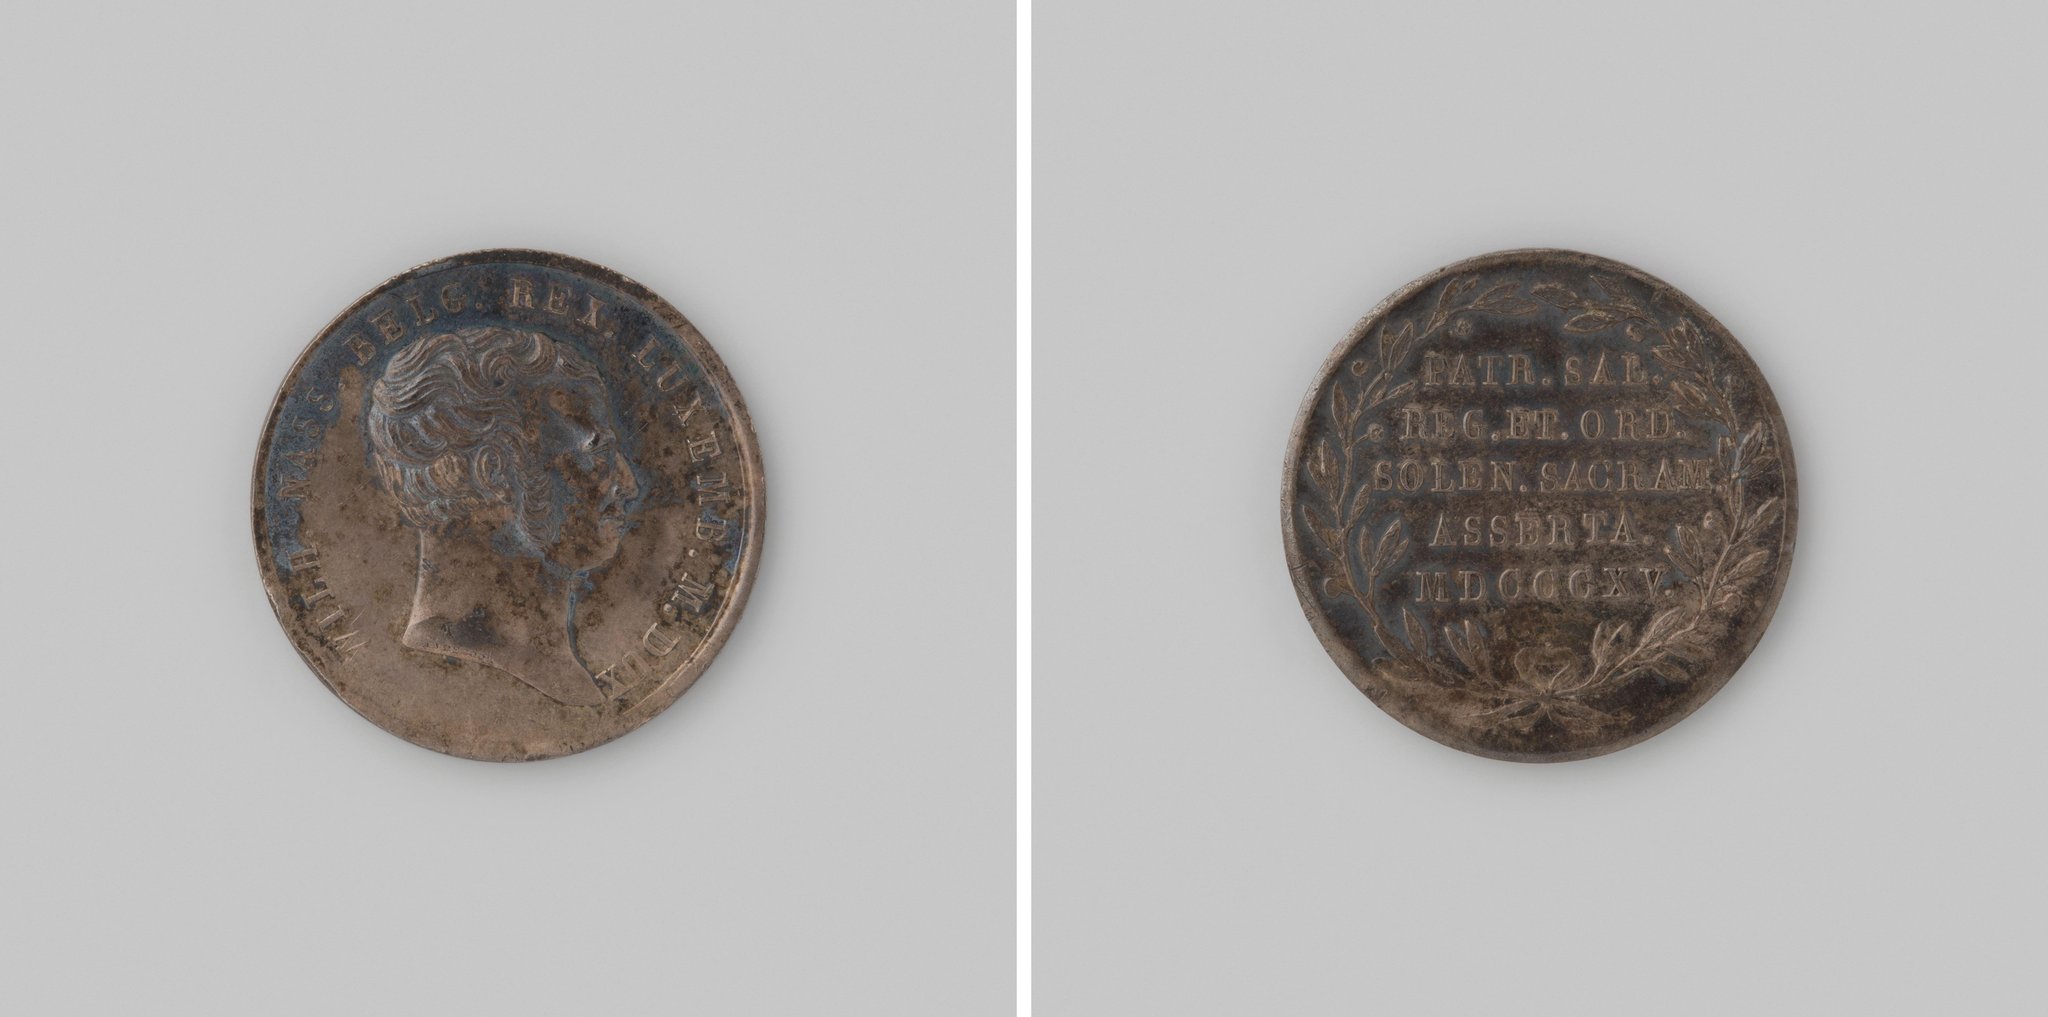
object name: history medal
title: Strooipenning bij de inhuldiging van Willem Frederik als Koning Willem I te Brussel 1815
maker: pierre wautier van de goor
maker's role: medailleur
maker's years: 1783-1851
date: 1815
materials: silver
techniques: striking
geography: brussels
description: Zilveren penning: op de voorzijde het portret van Willem I naar rechts, met omschrift, op de keerzijde vijf regels tekst tussen samengestrikte lauwerkransen.